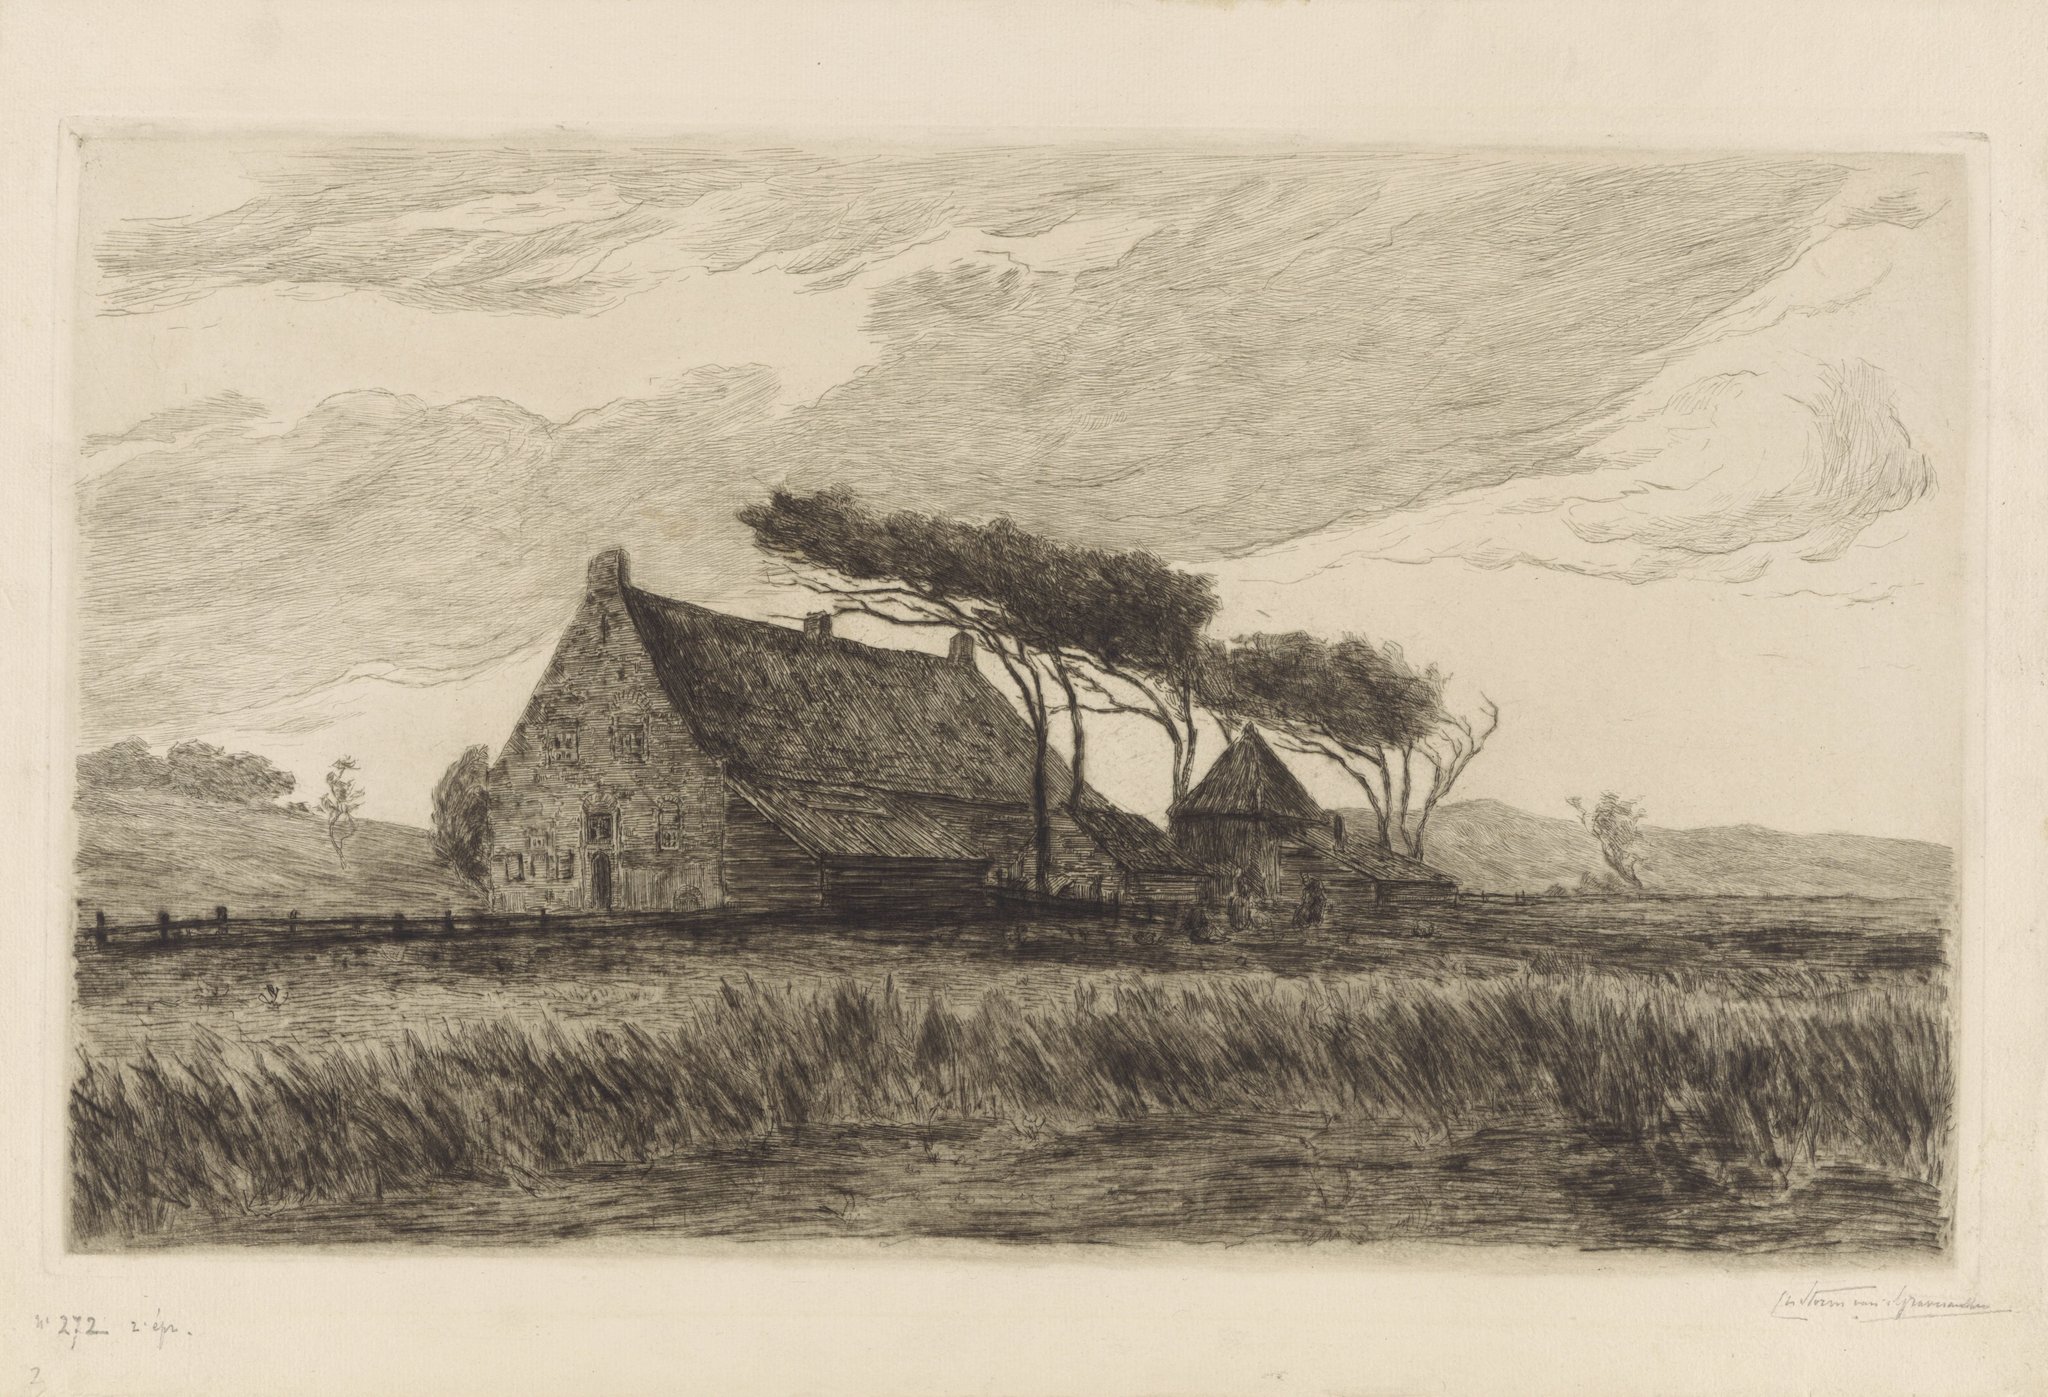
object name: print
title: Huis in de duinen bij Katwijk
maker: carel nicolaas storm van s-gravesande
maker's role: draughtsman, print maker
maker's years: 1841-1924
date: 1869-1902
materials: paper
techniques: drypoint, etching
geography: netherlands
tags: dunes (sea not visible); in the dunes, farm or solitary house in landscape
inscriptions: collector's mark: Lugt 2228, inscription: ‘2 épr.’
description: Huis in de duinen bij Katwijk. Rechts van het huis hoge gebogen bomen en een hooiberg.